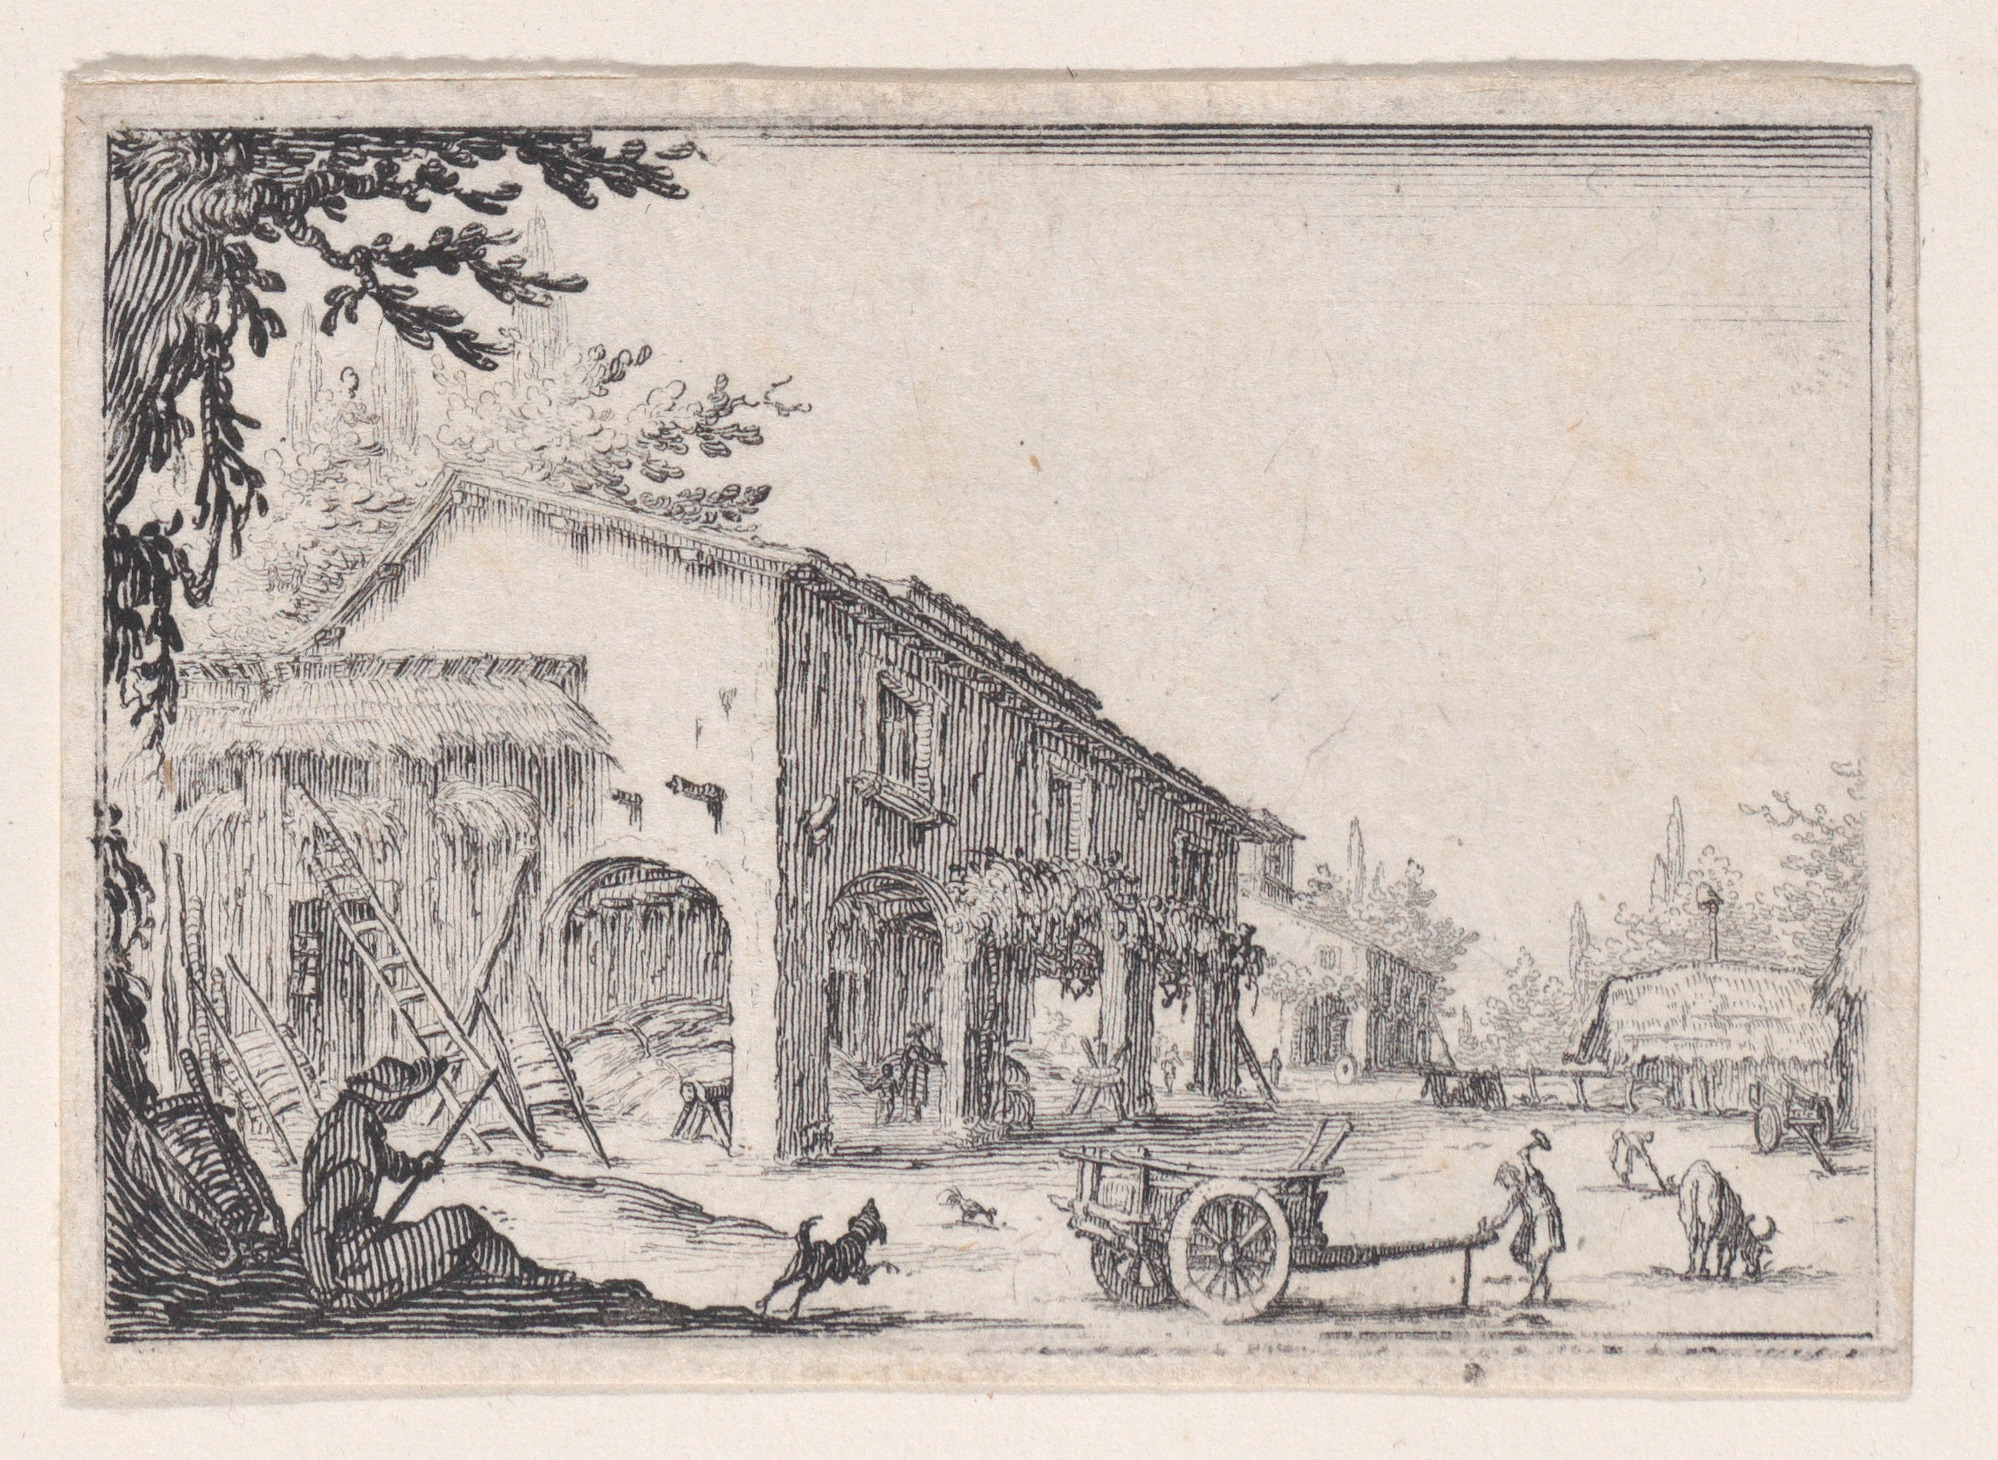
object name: print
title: La Factoria (The Factory), from Les Caprices Series A, The Florence Set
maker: jacques callot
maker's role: artist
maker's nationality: french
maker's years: 1592-1635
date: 1617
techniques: etching